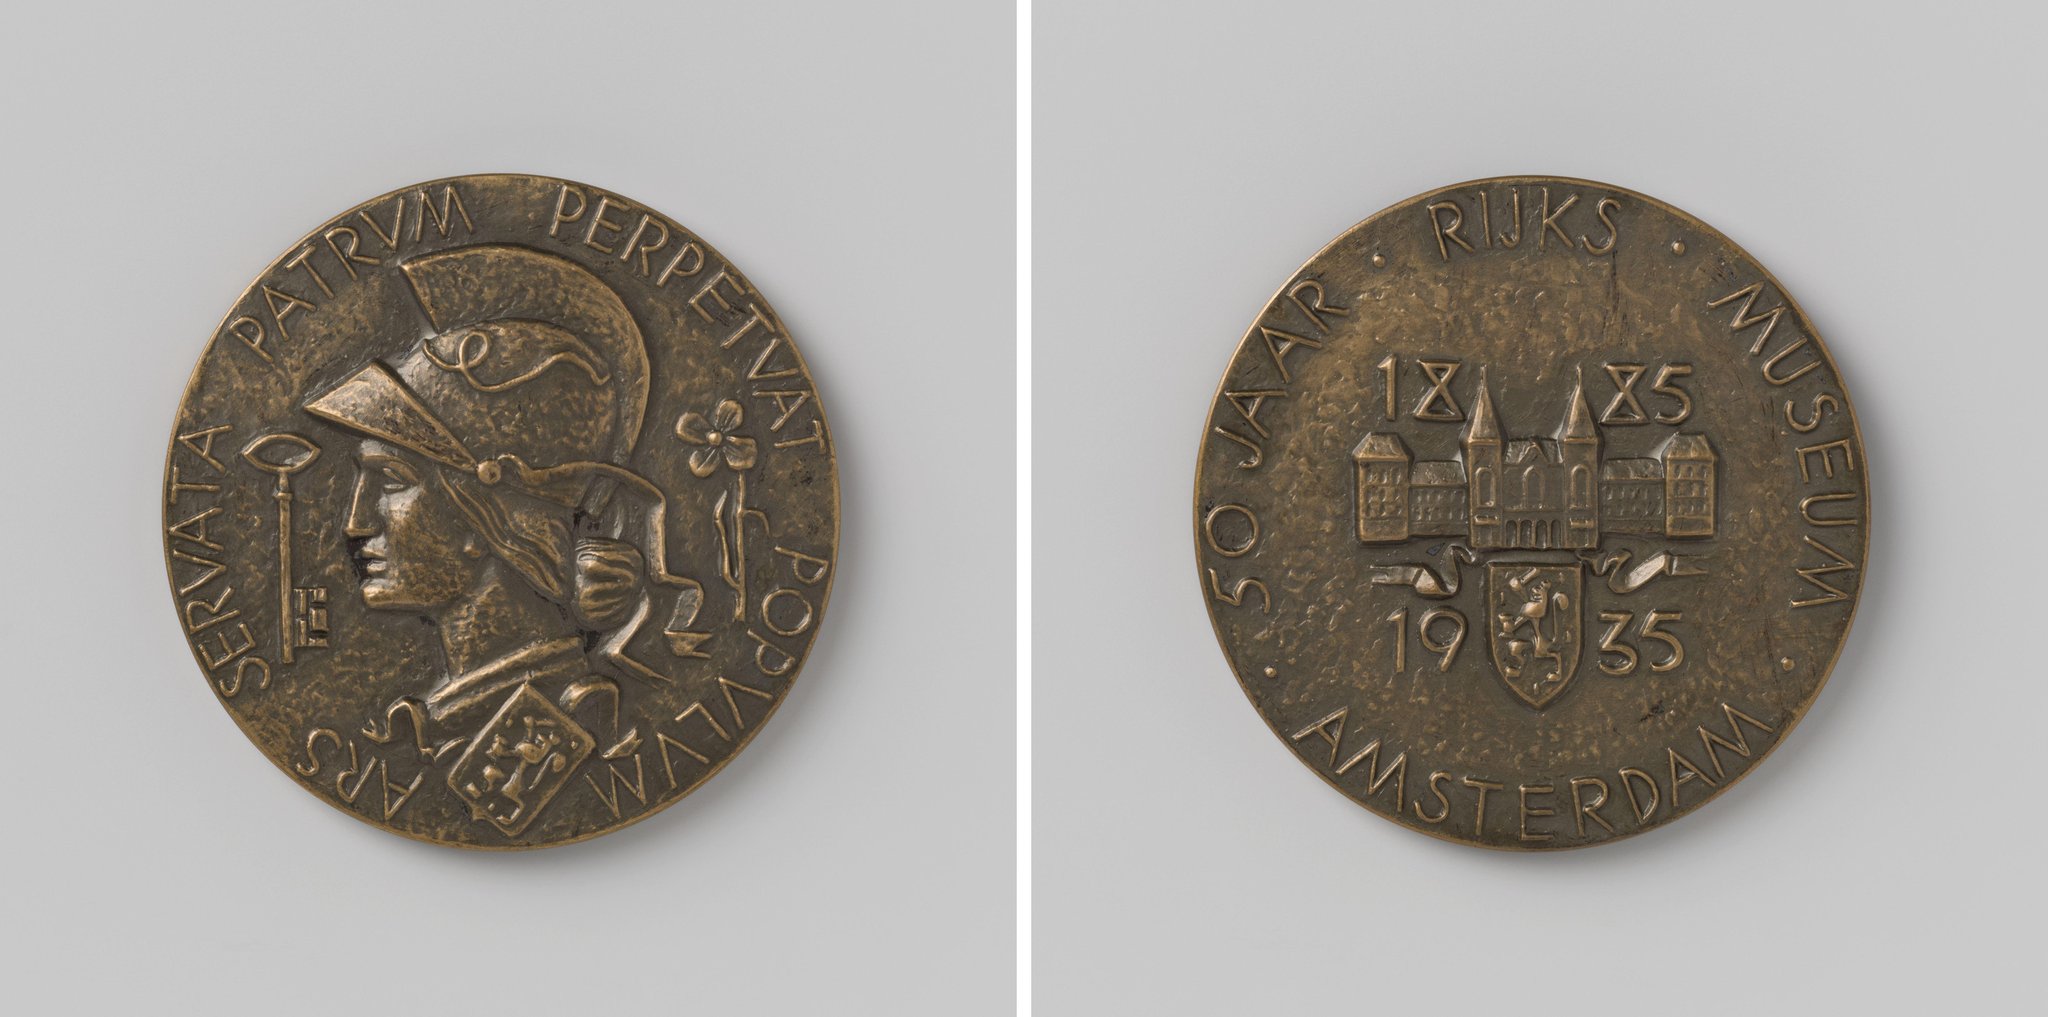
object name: history medal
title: Vijfig jaar Rijksmuseum Amsterdam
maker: dirk bus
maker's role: sculptor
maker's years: 1907-1978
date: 1935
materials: bronze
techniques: casting, striking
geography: netherlands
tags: rijksmuseum amsterdam, amsterdam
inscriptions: date